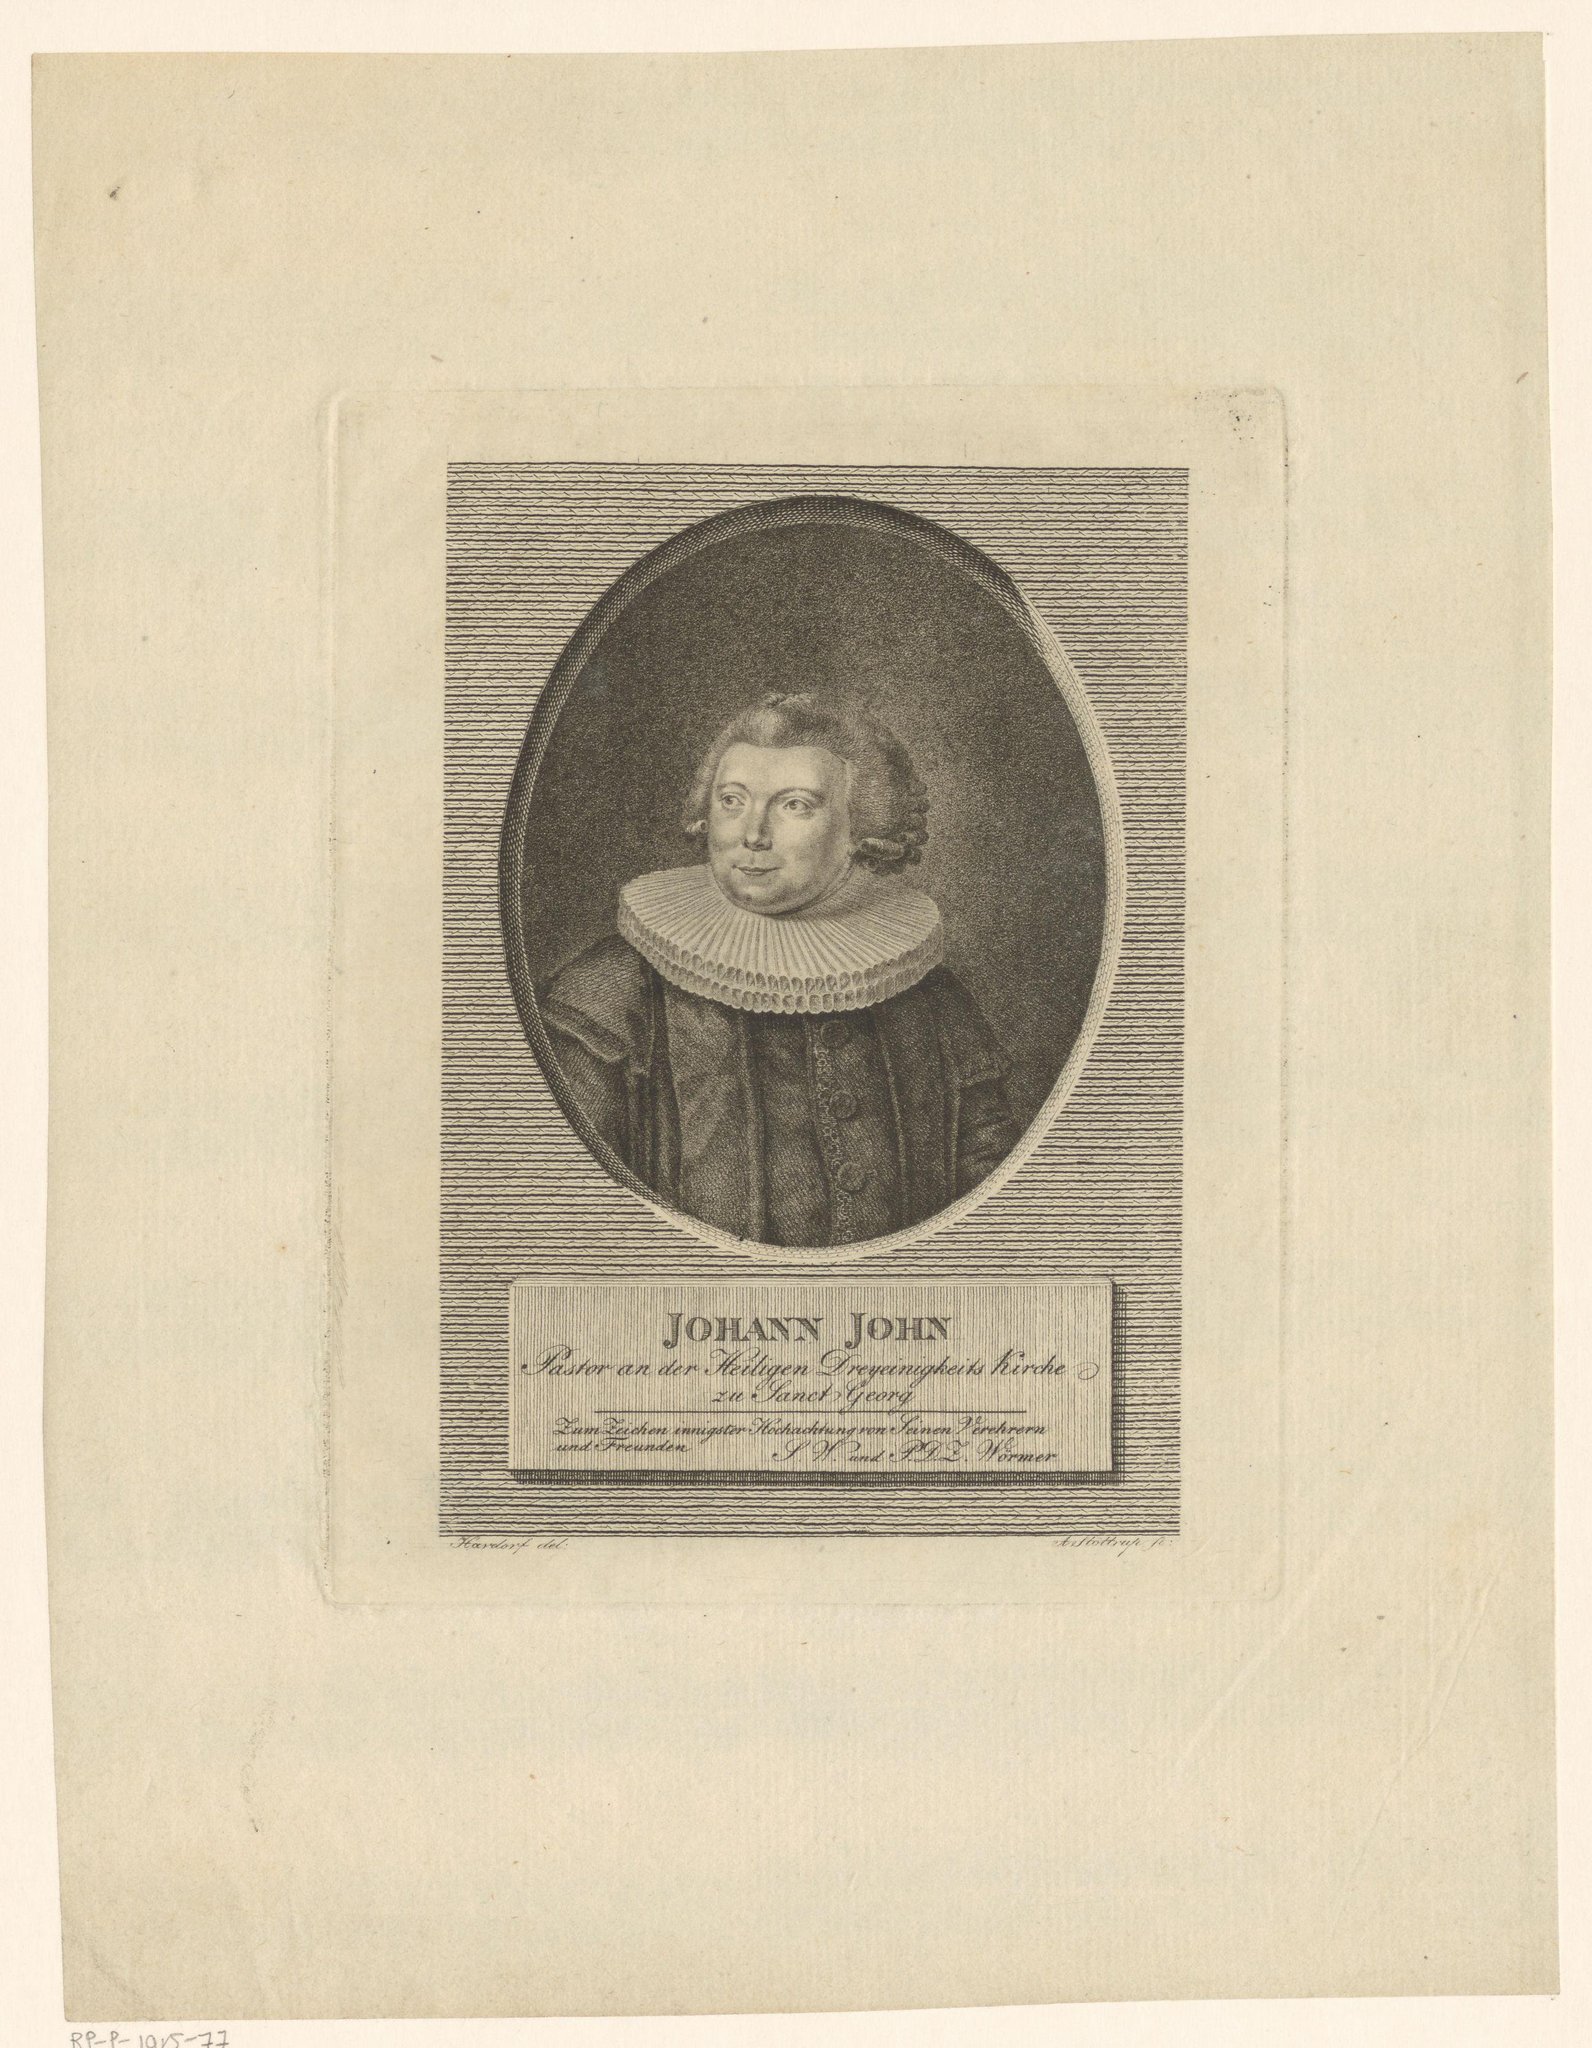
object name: print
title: Portret van Johann John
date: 1761-1812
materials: paper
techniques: engraving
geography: hamburg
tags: johann john, historical persons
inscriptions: collector's mark: Lugt 2228